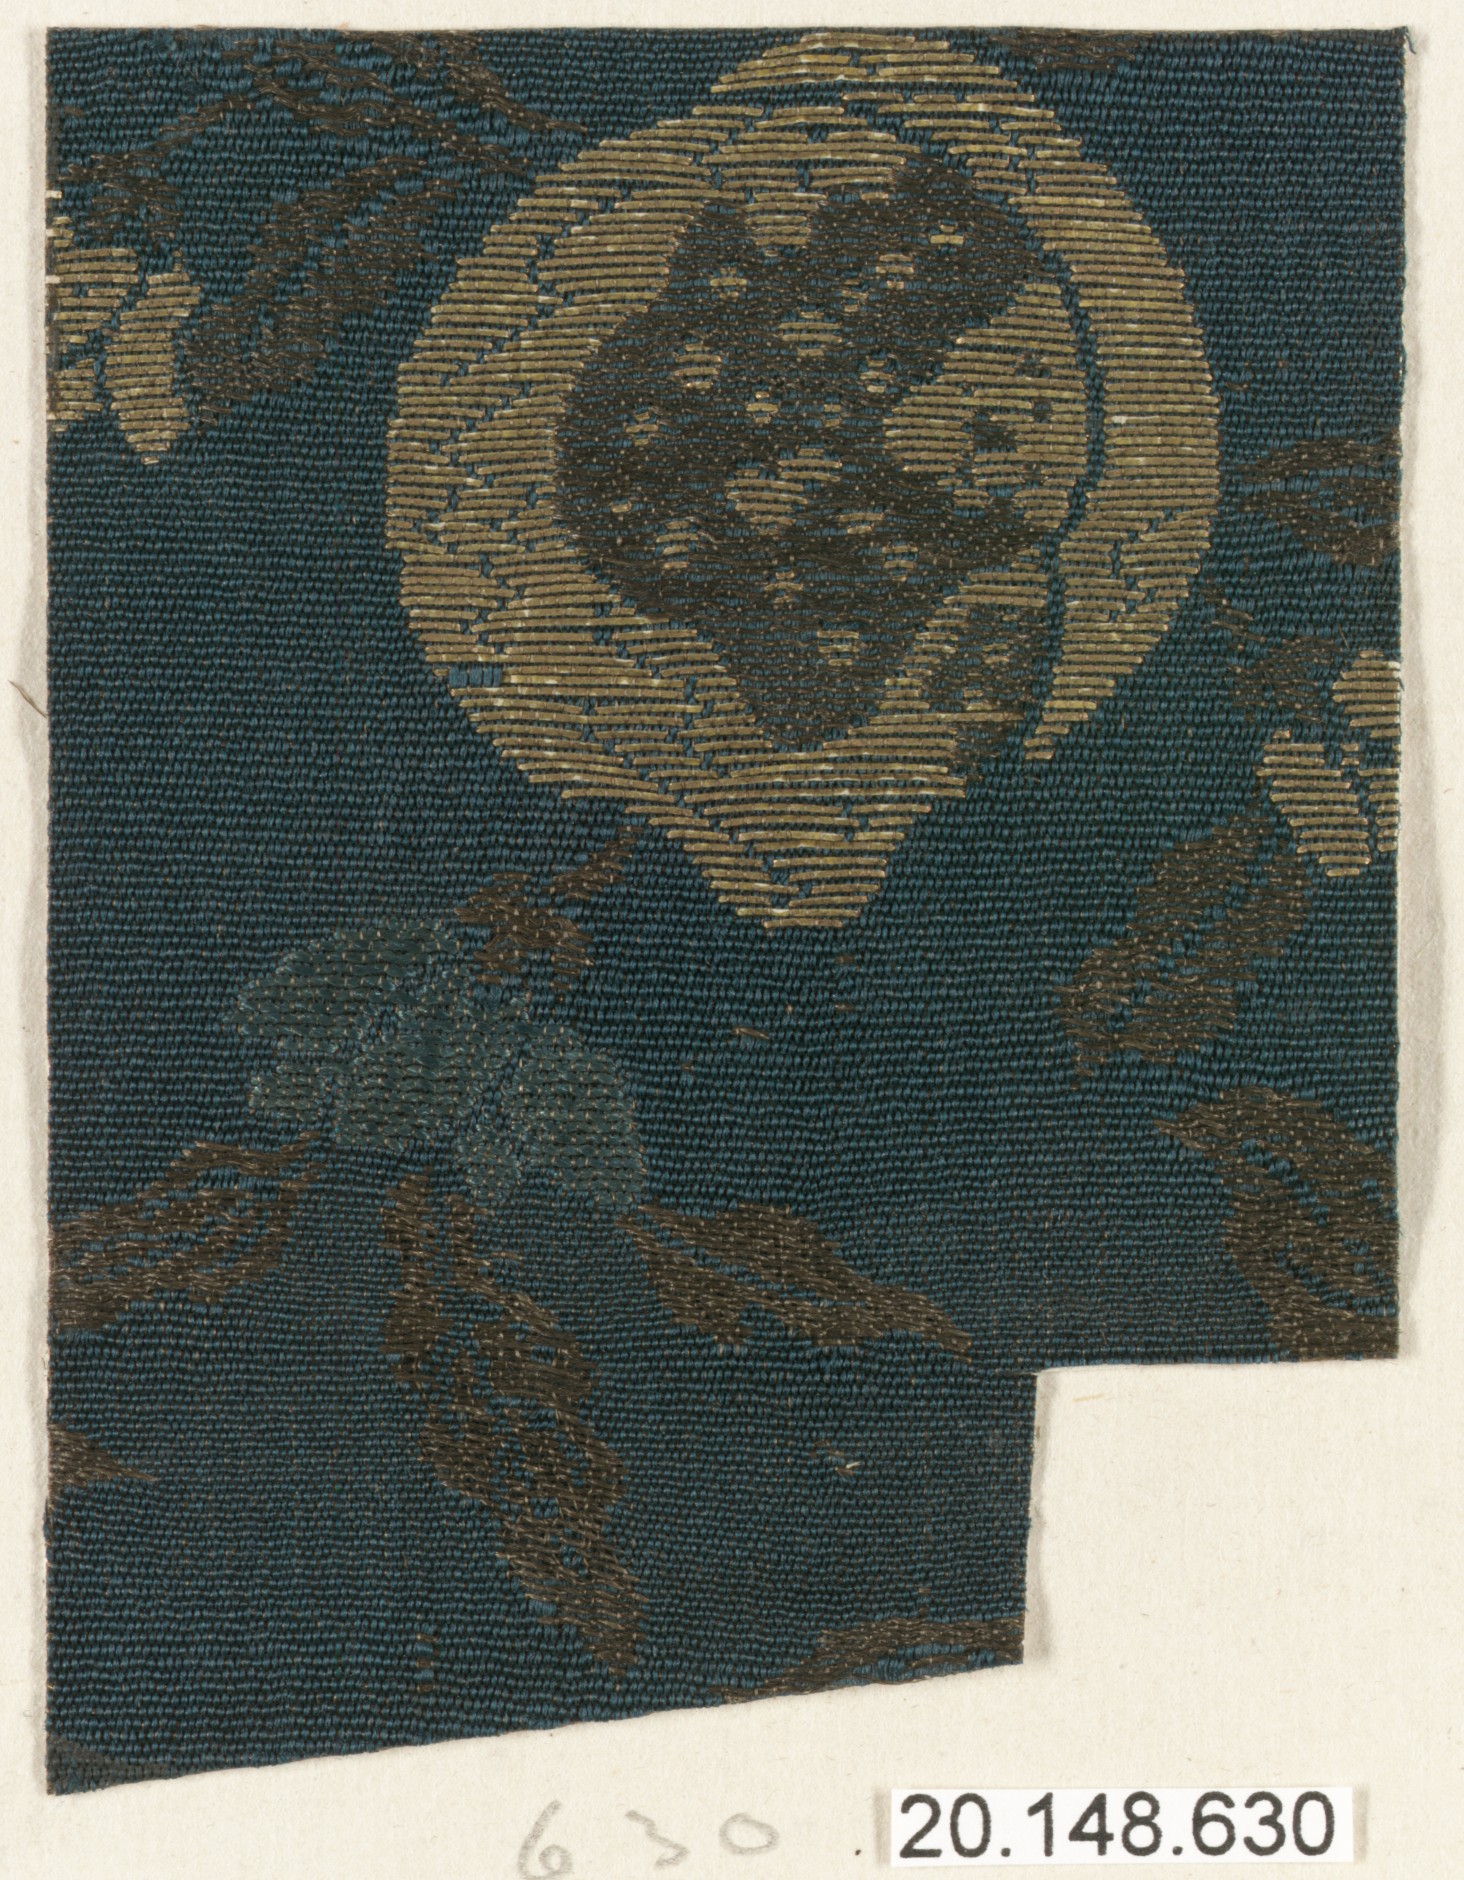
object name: piece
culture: japanese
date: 1701-1800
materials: silk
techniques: compound weave